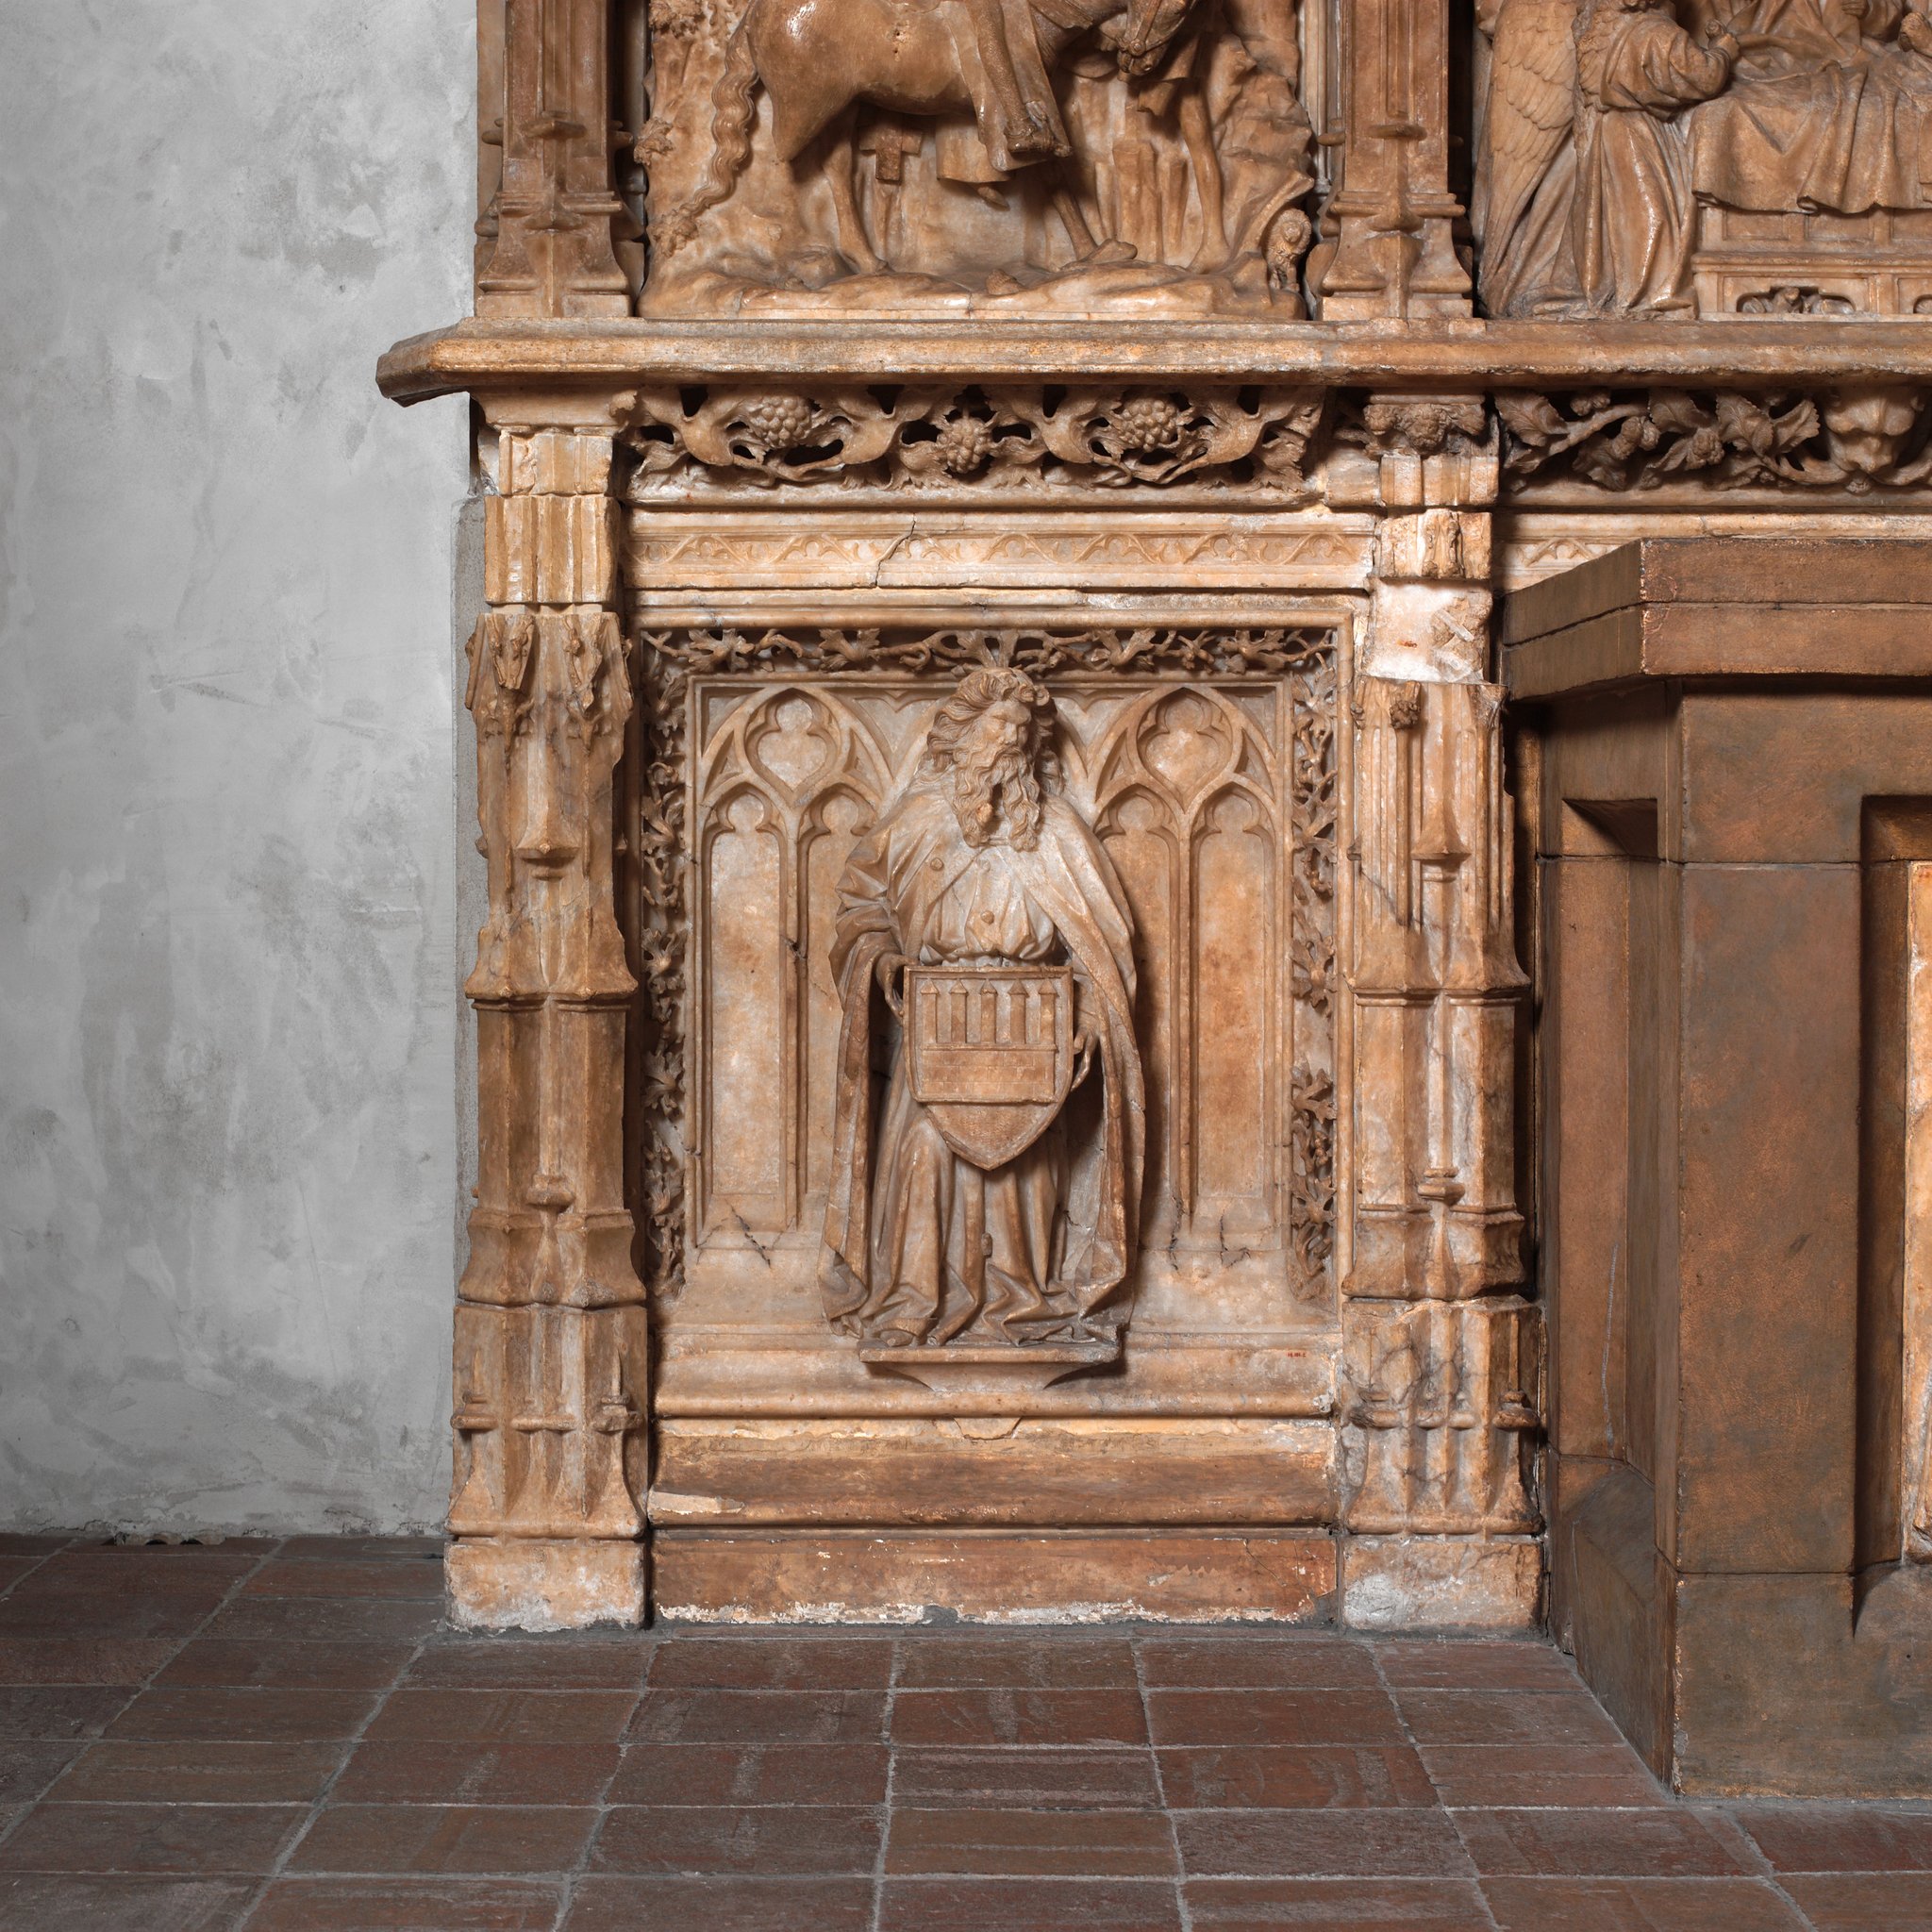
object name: altarpiece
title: Altar Predella and Socle of Archbishop Don Dalmau de Mur y Cervelló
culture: spanish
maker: francí gomar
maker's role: artist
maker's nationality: spanish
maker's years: 1443-1493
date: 1456-1458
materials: alabaster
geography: spain